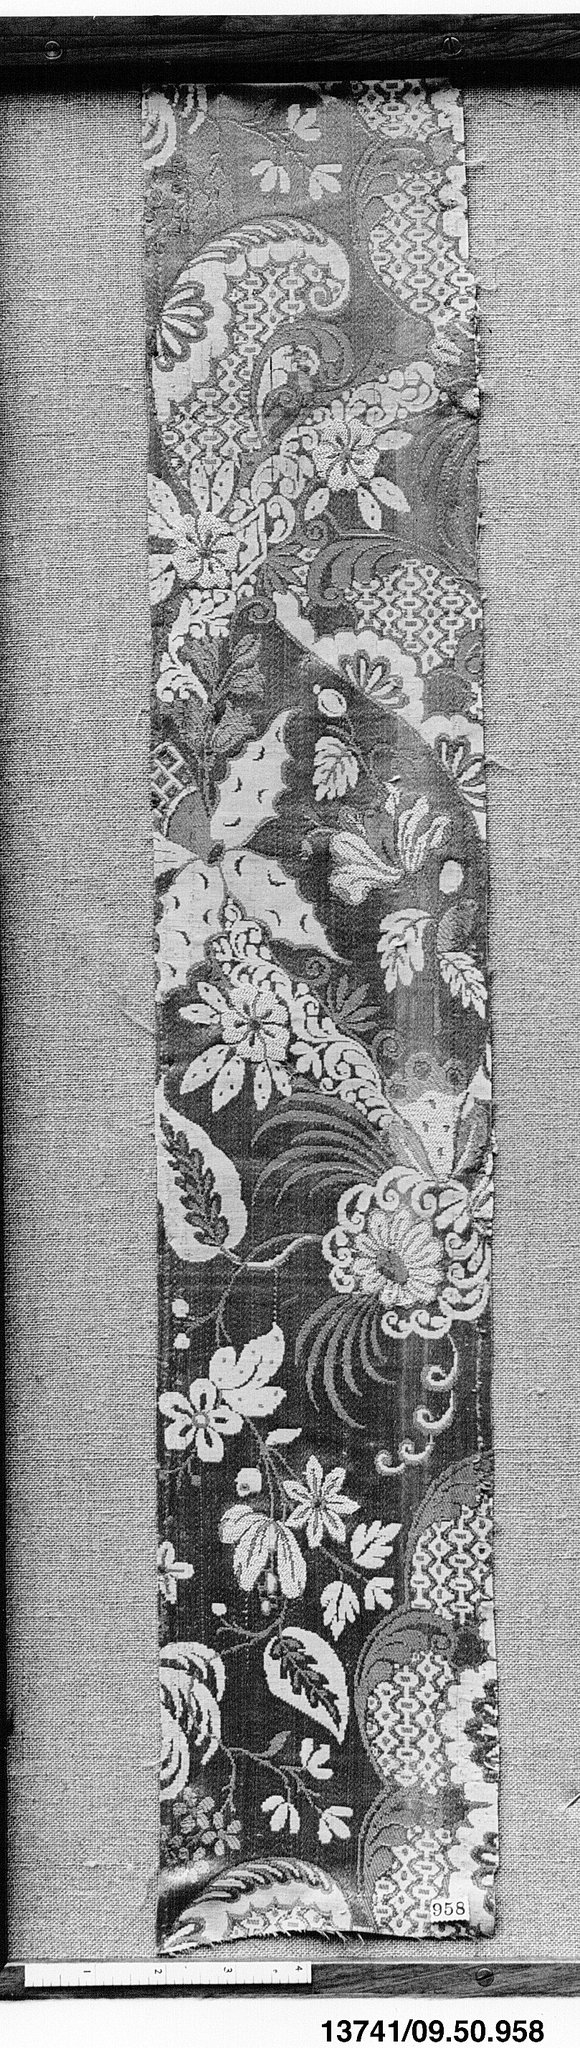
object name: piece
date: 1667-1733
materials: silk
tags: flowers,leaves